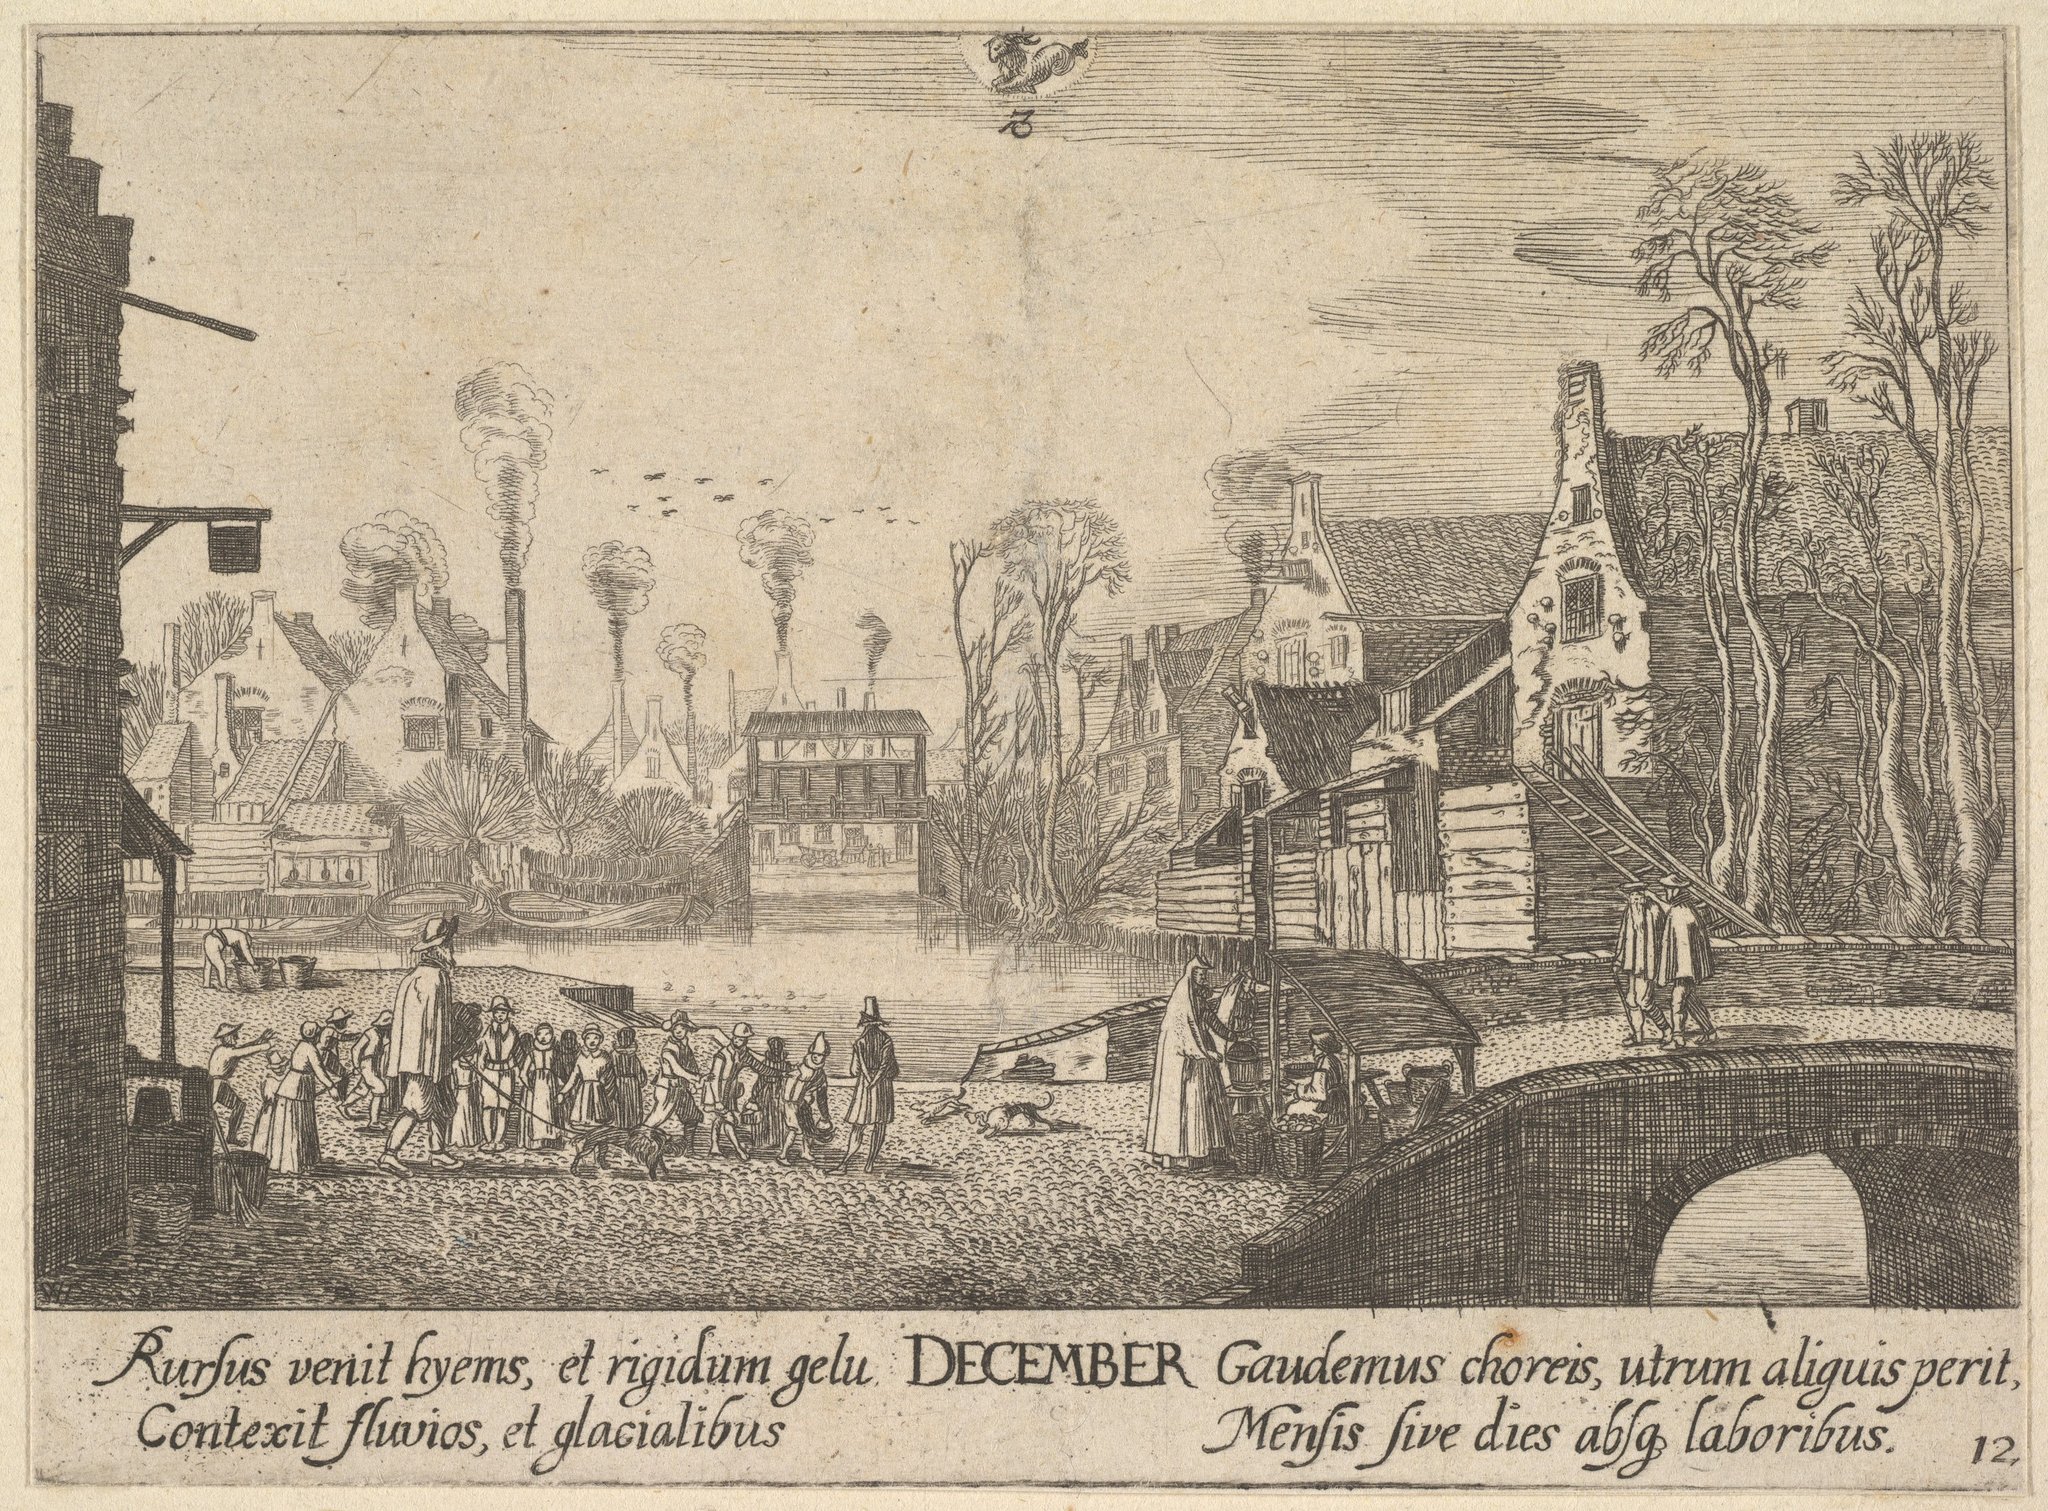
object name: print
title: December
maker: wenceslaus hollar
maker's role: artist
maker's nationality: bohemian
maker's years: 1607-1677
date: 1628-1629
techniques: etching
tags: buildings,bridges,towns